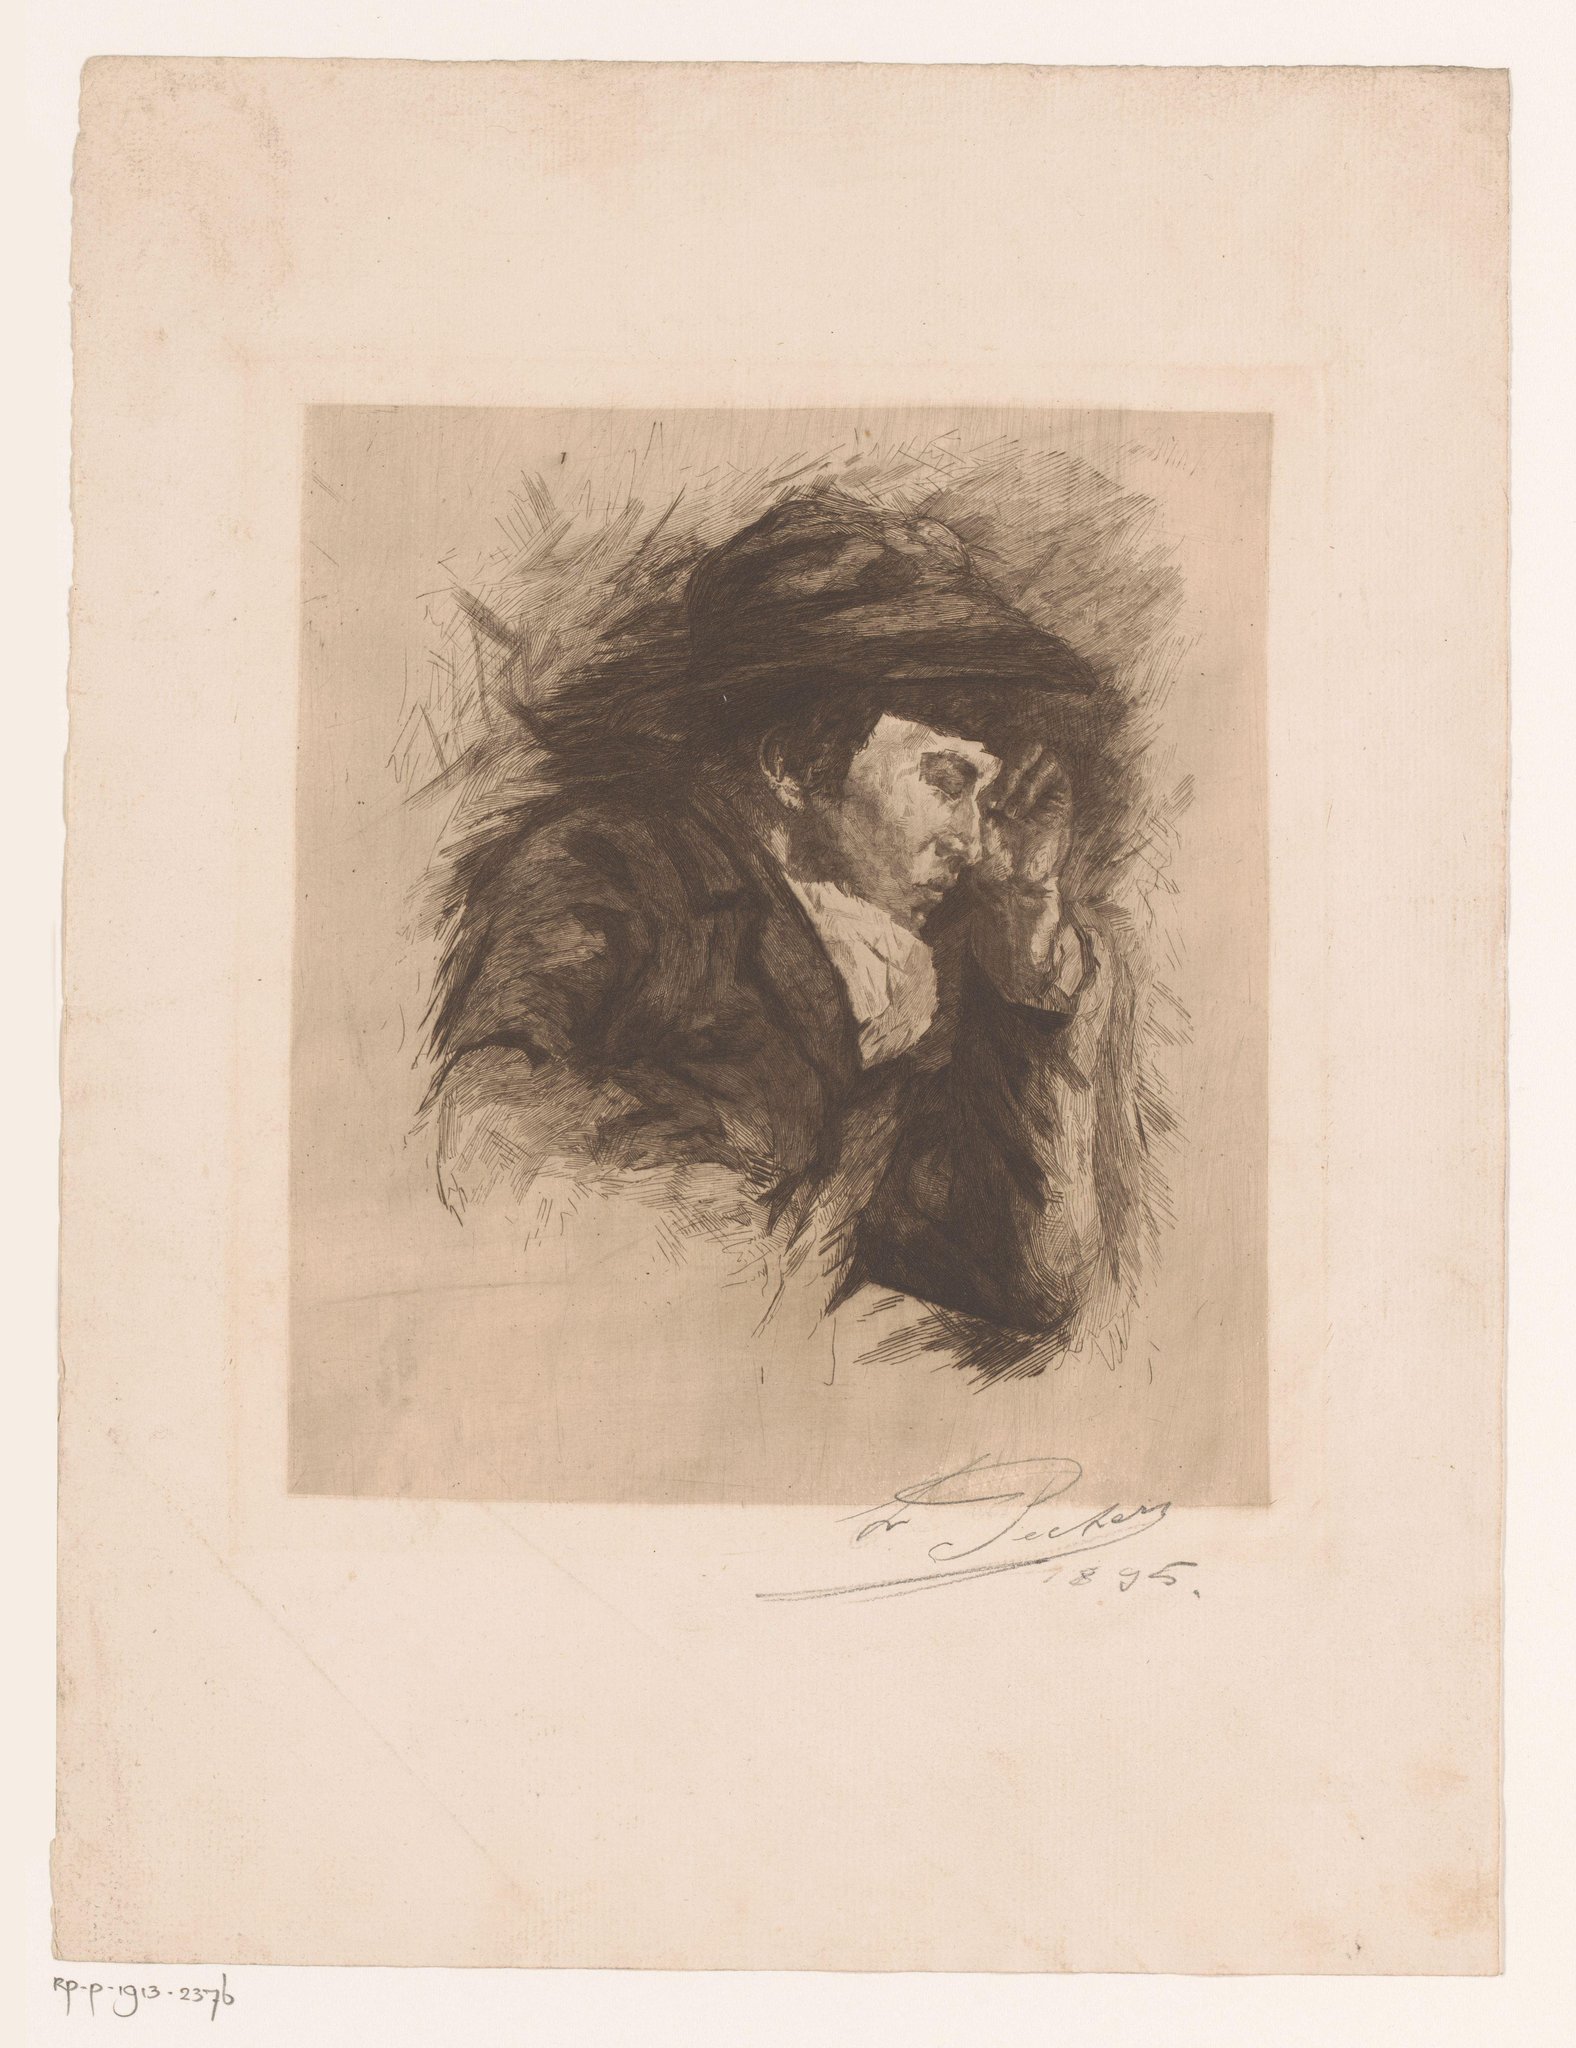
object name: print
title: Man wrijft zich in het oog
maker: louis peeters (i)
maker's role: print maker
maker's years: 1876-1964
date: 1895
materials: paper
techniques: drypoint, etching, intaglio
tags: anonymous historical person portrayed alone, rubbing one's eyes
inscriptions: date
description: Geboorte- en sterfdatum van de prentmaker zijn onbekend. Daarom is voor de bepaling van de rechten van dit object gebruik gemaakt van de verwervingsdatum Rijksmuseum Amsterdam.